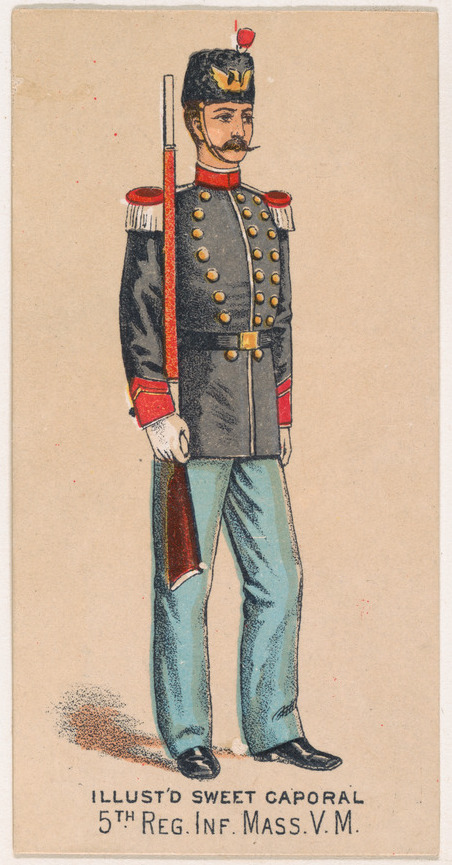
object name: print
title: 5th Regiment Inf., Massachusetts, V.M., from the Military Series (N224) issued by Kinney Tobacco Company to promote Sweet Caporal Cigarettes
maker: kinney brothers tobacco company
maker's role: publisher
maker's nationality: american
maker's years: 1869-2011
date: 1888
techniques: color lithograph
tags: soldiers,men